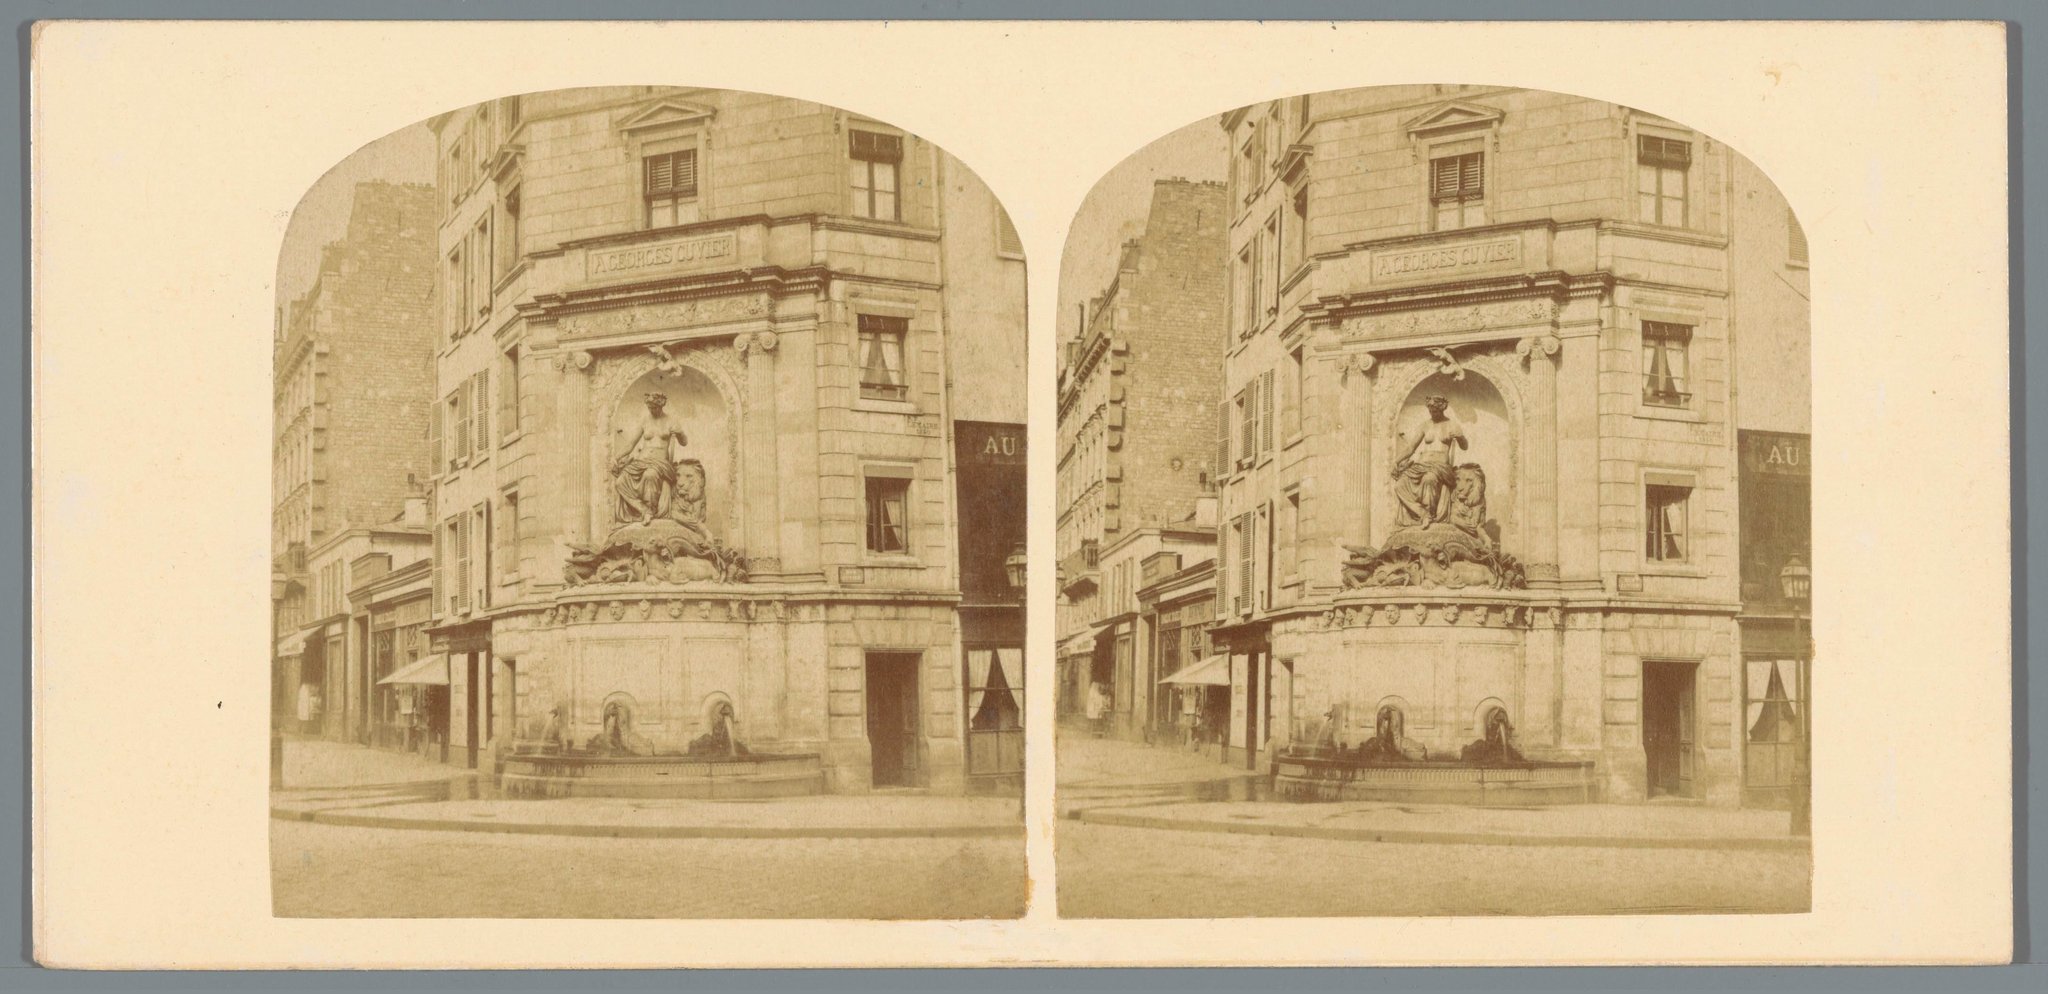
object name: stereograph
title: Gezicht op de Fontaine Cuvier in Parijs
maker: Anonymous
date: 1860-1865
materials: cardboard, photographic support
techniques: albumen print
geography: paris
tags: ornamental fountain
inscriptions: inscription: ‘Parijs (Frankrijk) Fontaine Cuvier’